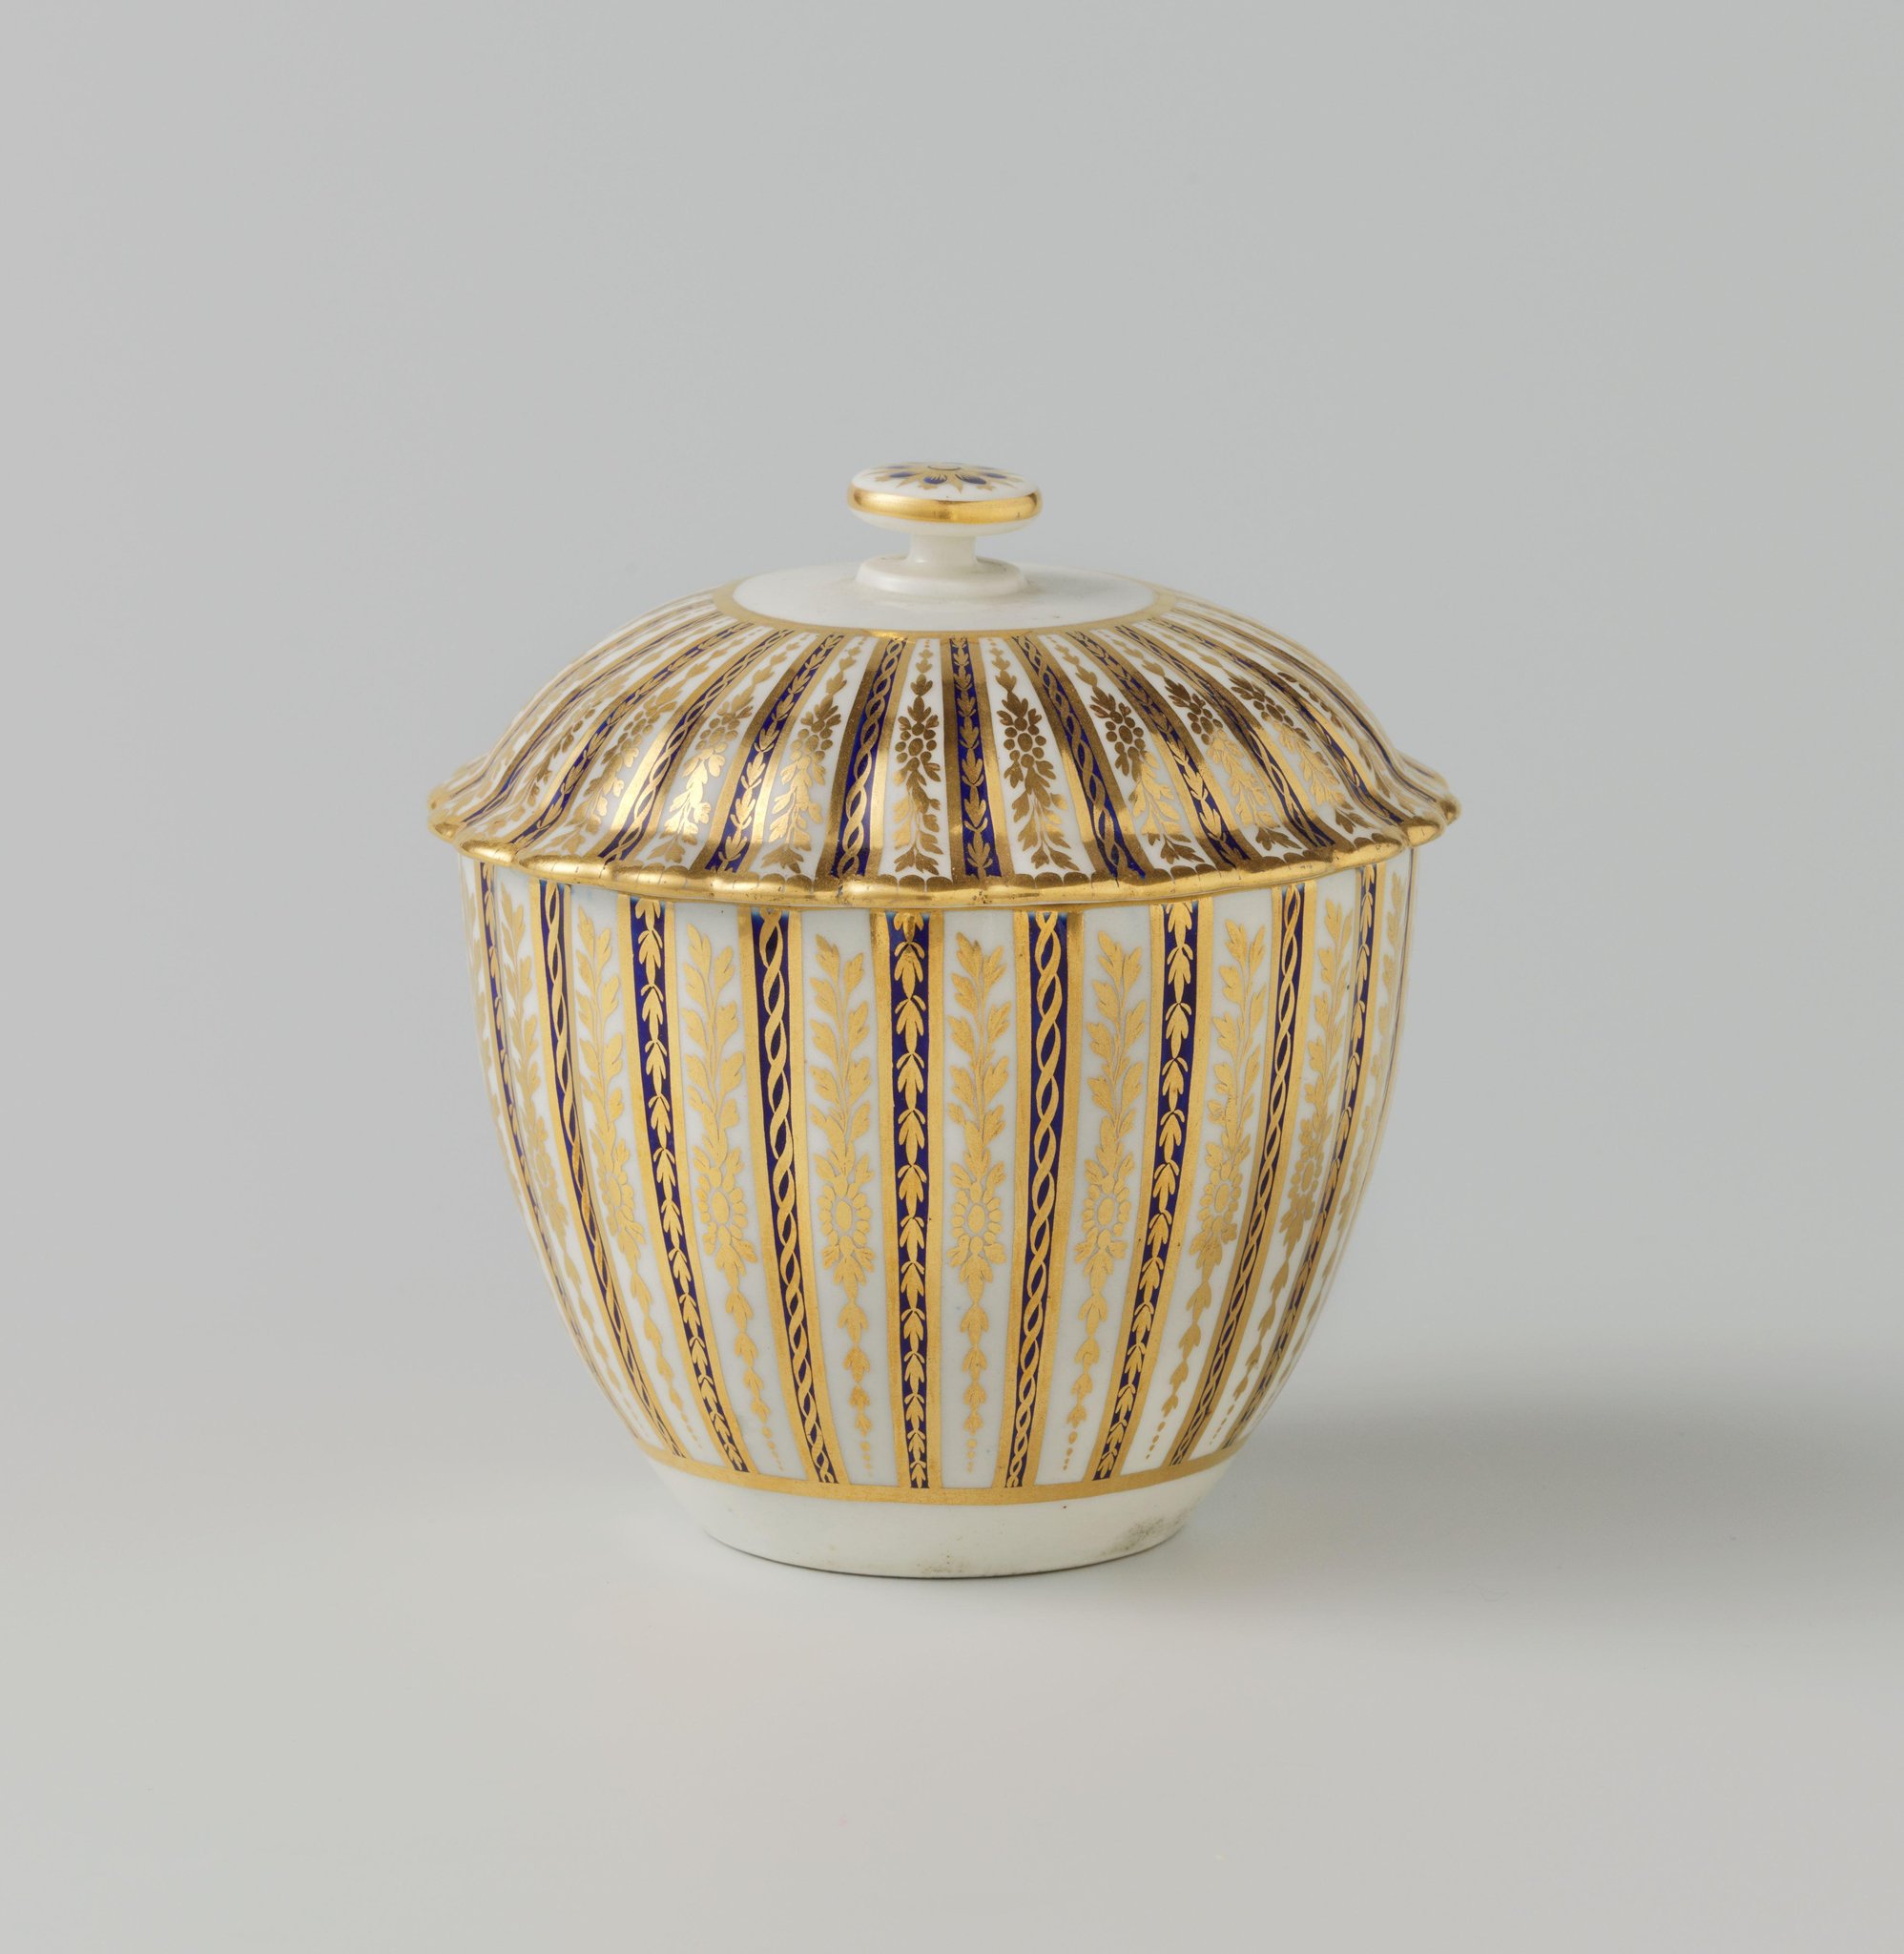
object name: lid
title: Deksel van een suikerpot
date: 1775-1800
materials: earthenware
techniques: vitrification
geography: worcester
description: Deksel van een suikerpot (BK-NM-I-Z-B-1).